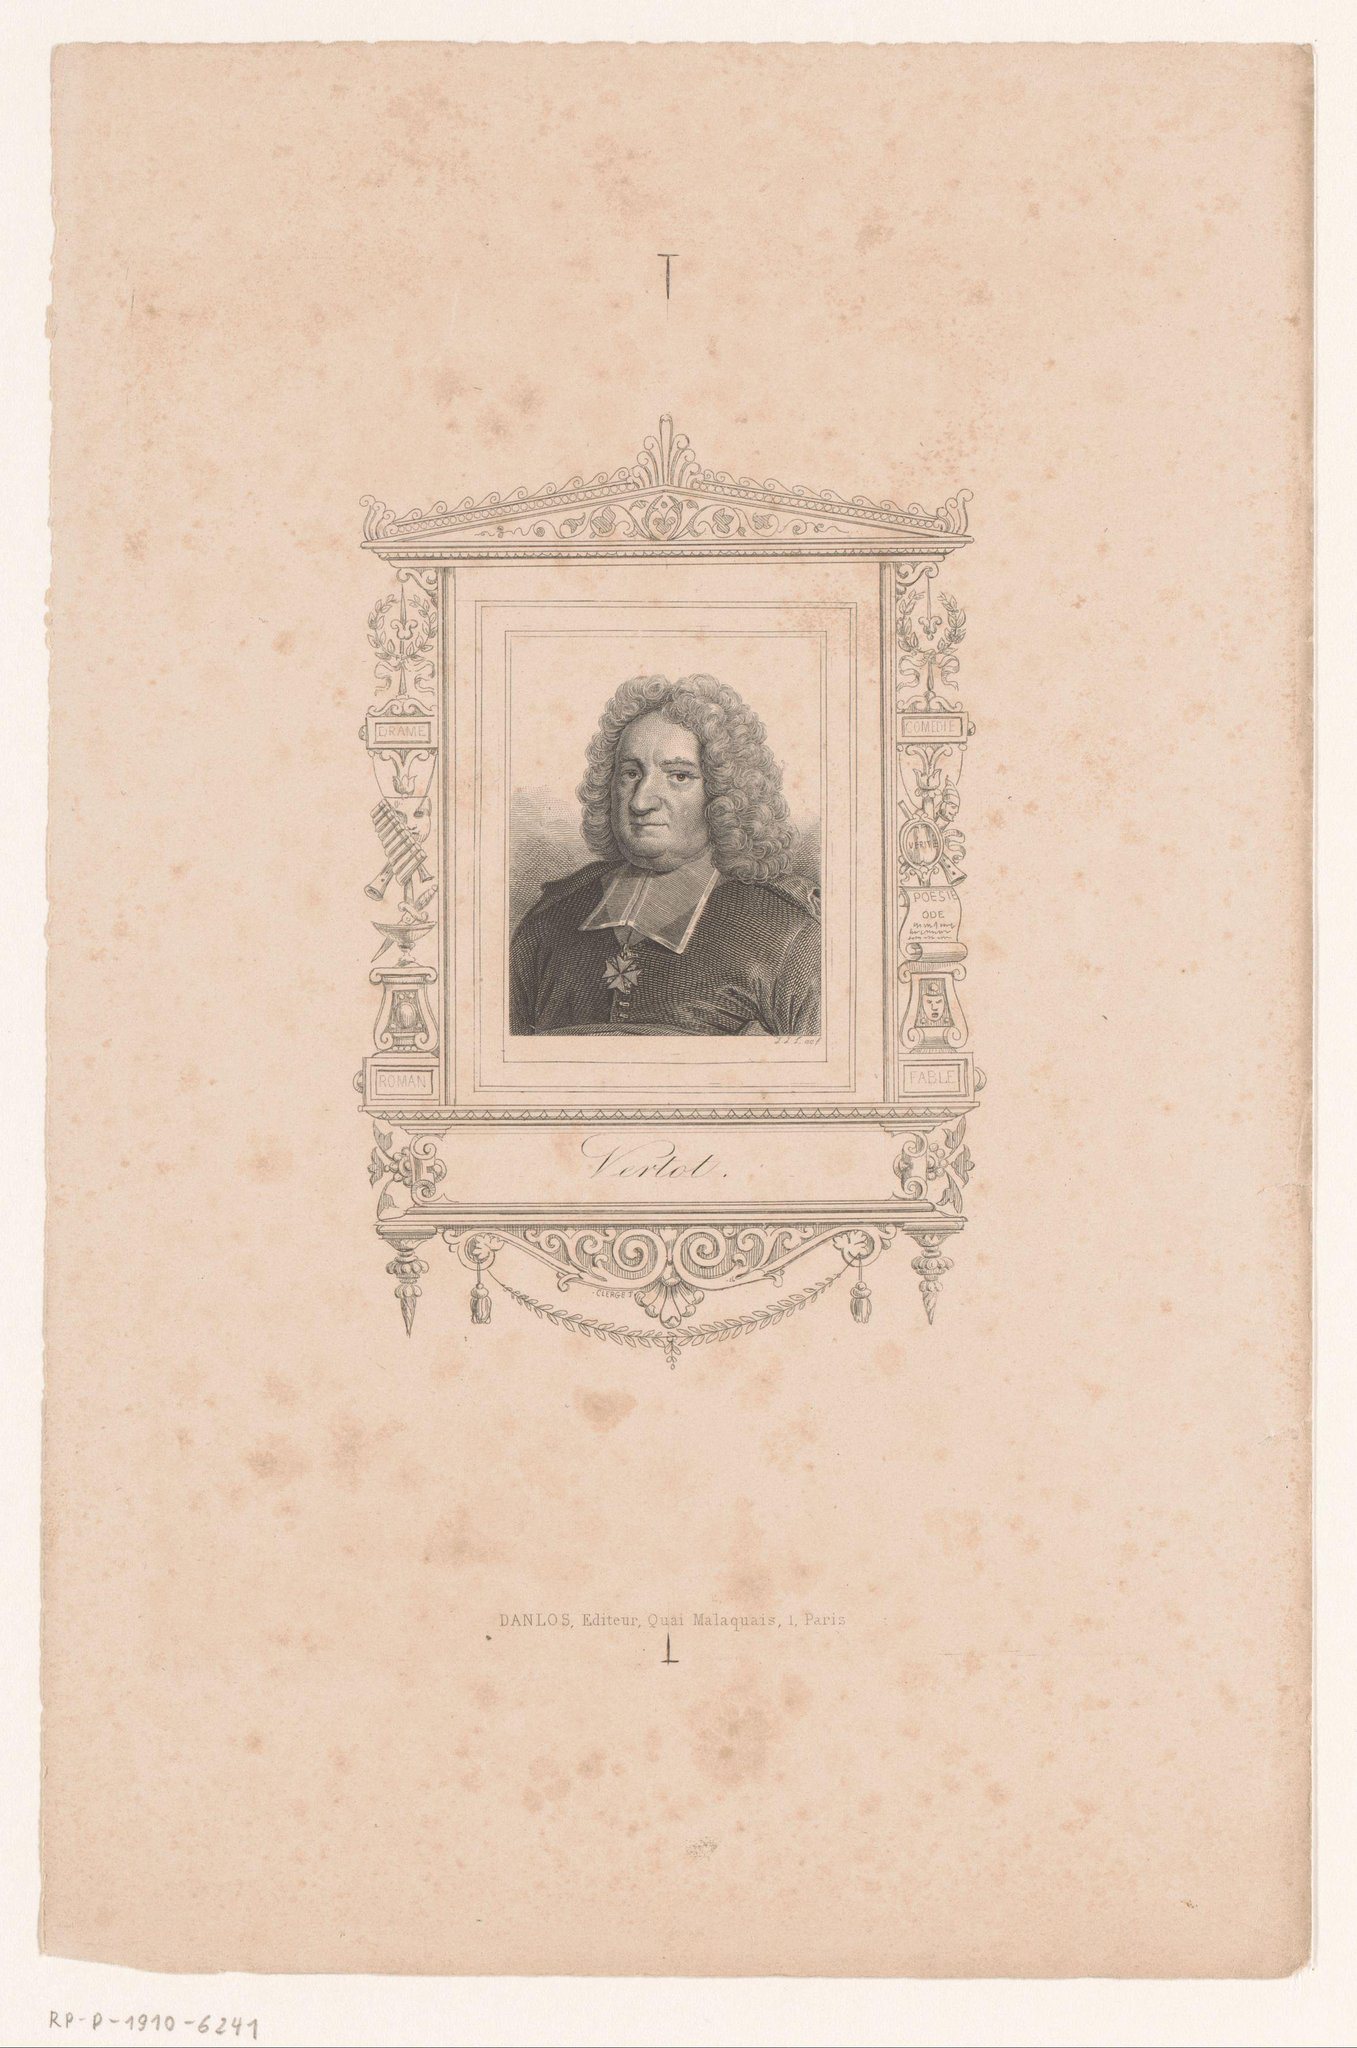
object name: print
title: Portret van René-Aubert Vertot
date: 1828-1870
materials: paper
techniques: engraving, etching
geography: paris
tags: paris, priest, historical persons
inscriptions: collector's mark: Lugt 2228